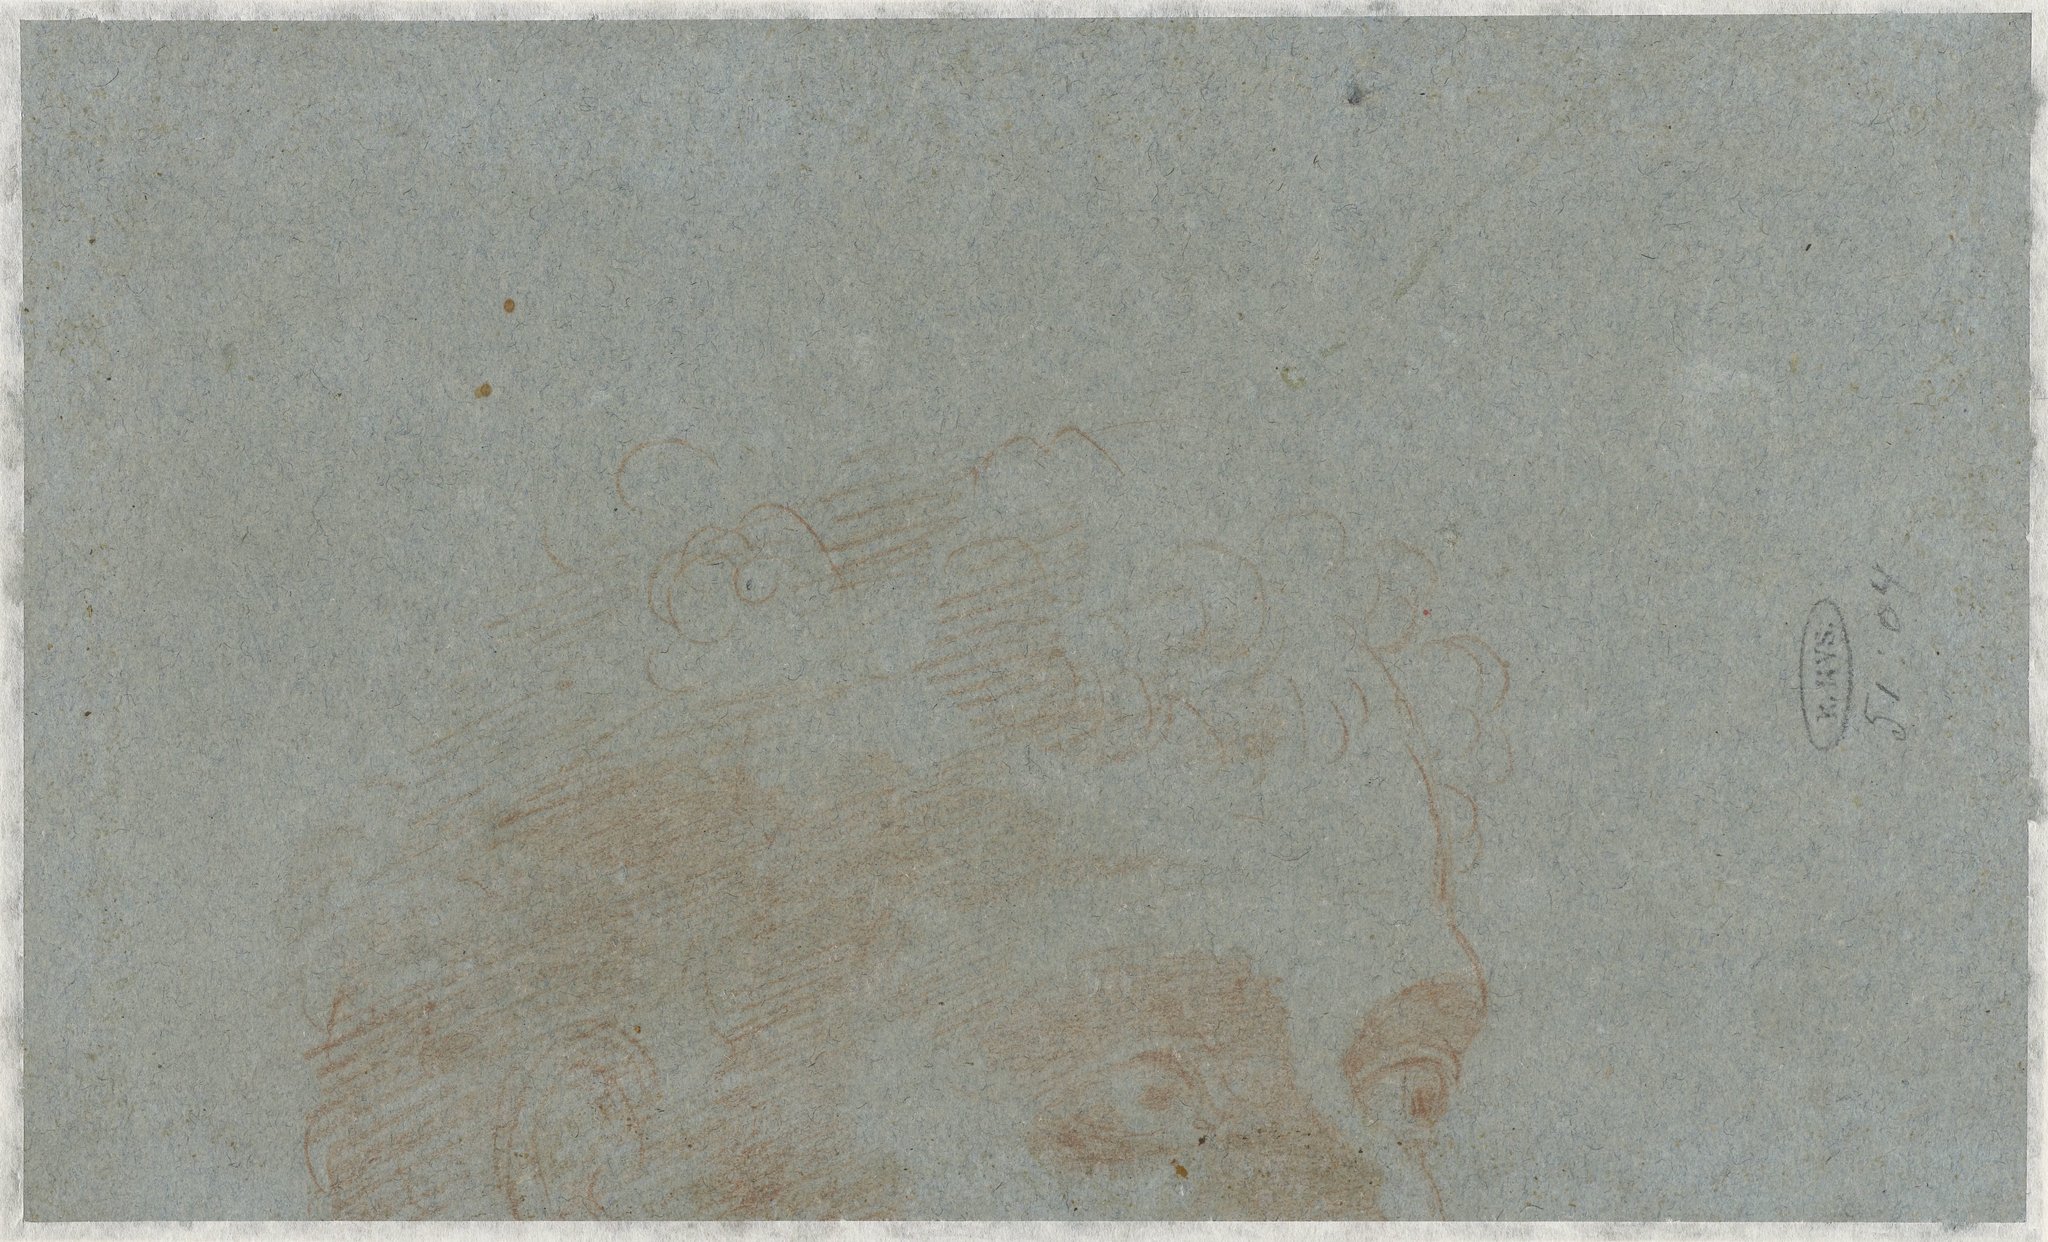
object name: drawing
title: Deel van het hoofd van een man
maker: bernardino lanino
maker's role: draughtsman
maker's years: 1510-1583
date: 1522-1583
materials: chalk, paper